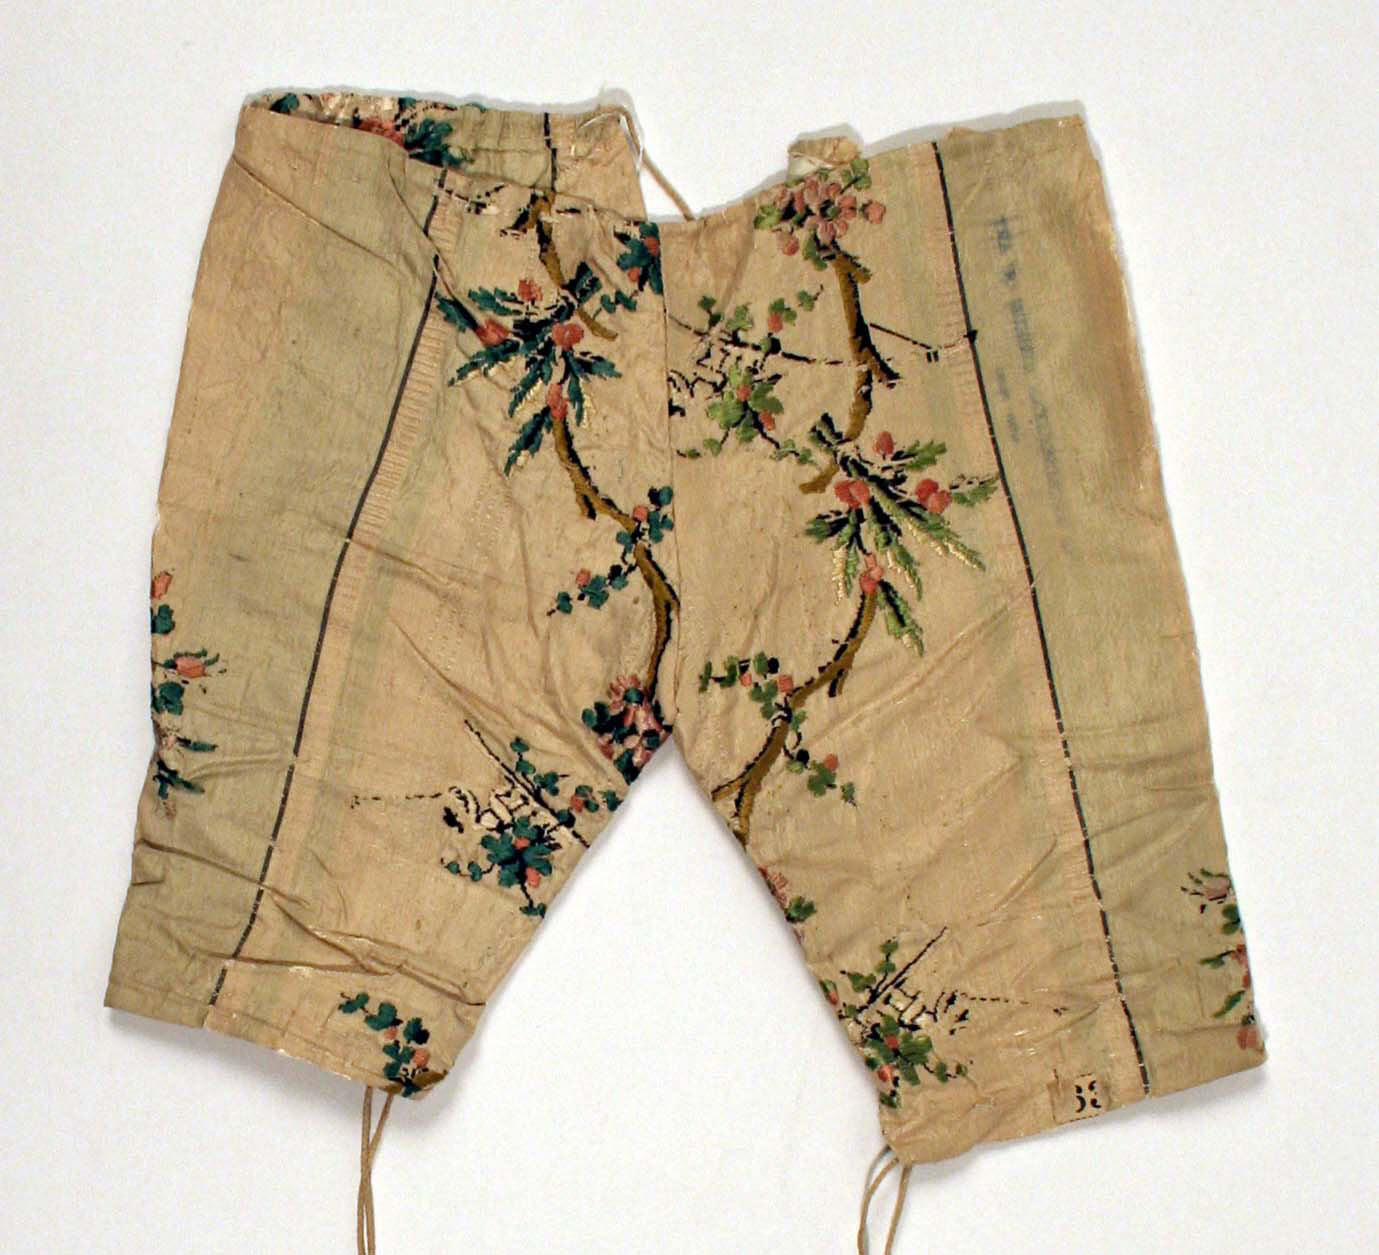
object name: doll accessory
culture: french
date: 1701-1800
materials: silk